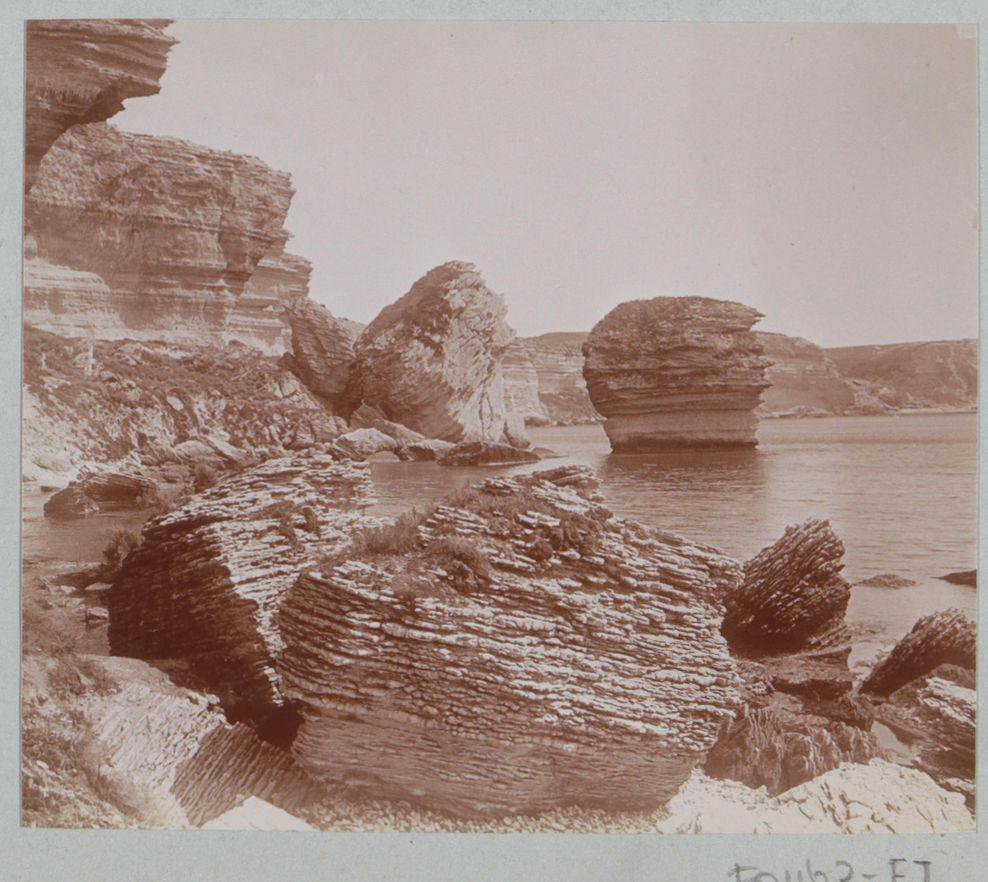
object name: photograph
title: Gezicht op de kliffen bij Bonifacio op Corsica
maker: Anonymous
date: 1905-1910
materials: paper, photographic support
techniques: gelatin silver print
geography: bonifacio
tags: coastal cliff or crag, prospect of city, town panorama, silhouette of city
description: Onderdeel van Fotoalbum van een Franse amateurfotograaf met bezienswaardigheden in Frankrijk, Zwitserland en Italië.